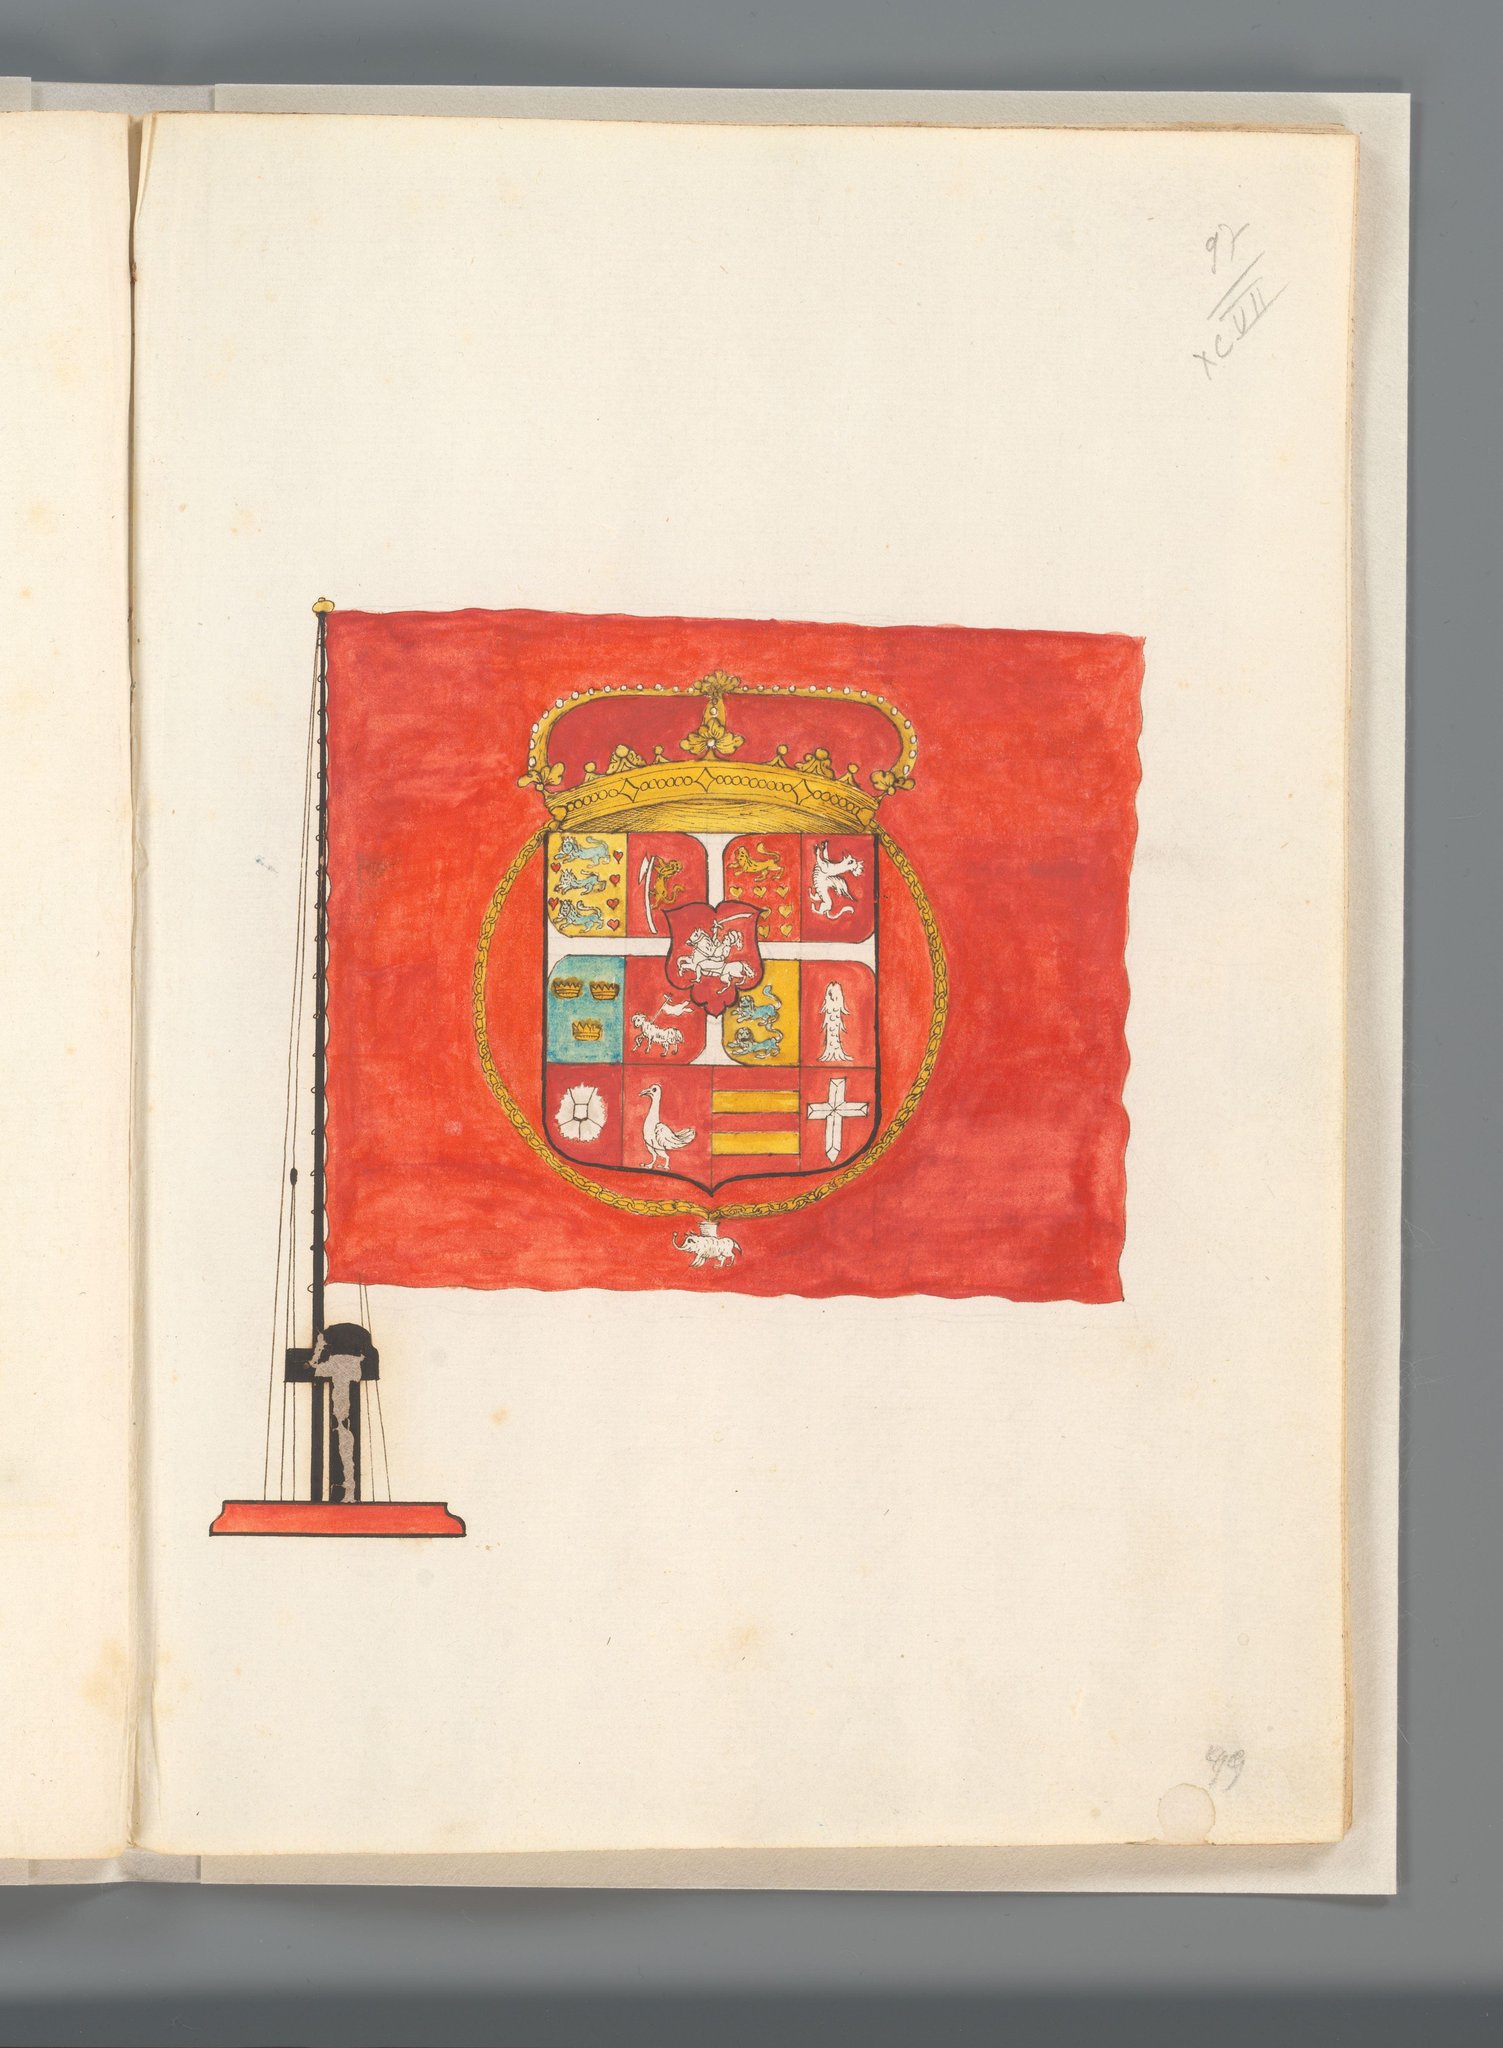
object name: drawing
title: Vlag van Denemarken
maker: Anonymous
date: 1667-1670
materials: ink, paper, watercolor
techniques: brush, pen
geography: france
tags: flag, colours (as symbol of the state, etc.), denmark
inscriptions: number: ‘97 / XCVII / 99’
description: Vlag van Denemarken. Het wapen van het Koninkrijk Denemarken, bekroond met een koningskroon en omhangen met de keten van de Orde van de Olifant. Vlag op vlaggensteng en mastvoet. Afgebeeld op folio 50r. Onderdeel van een vlaggenboek met vlaggen uit Europa, Noord-Afrika, Nabije en Verre Oosten.